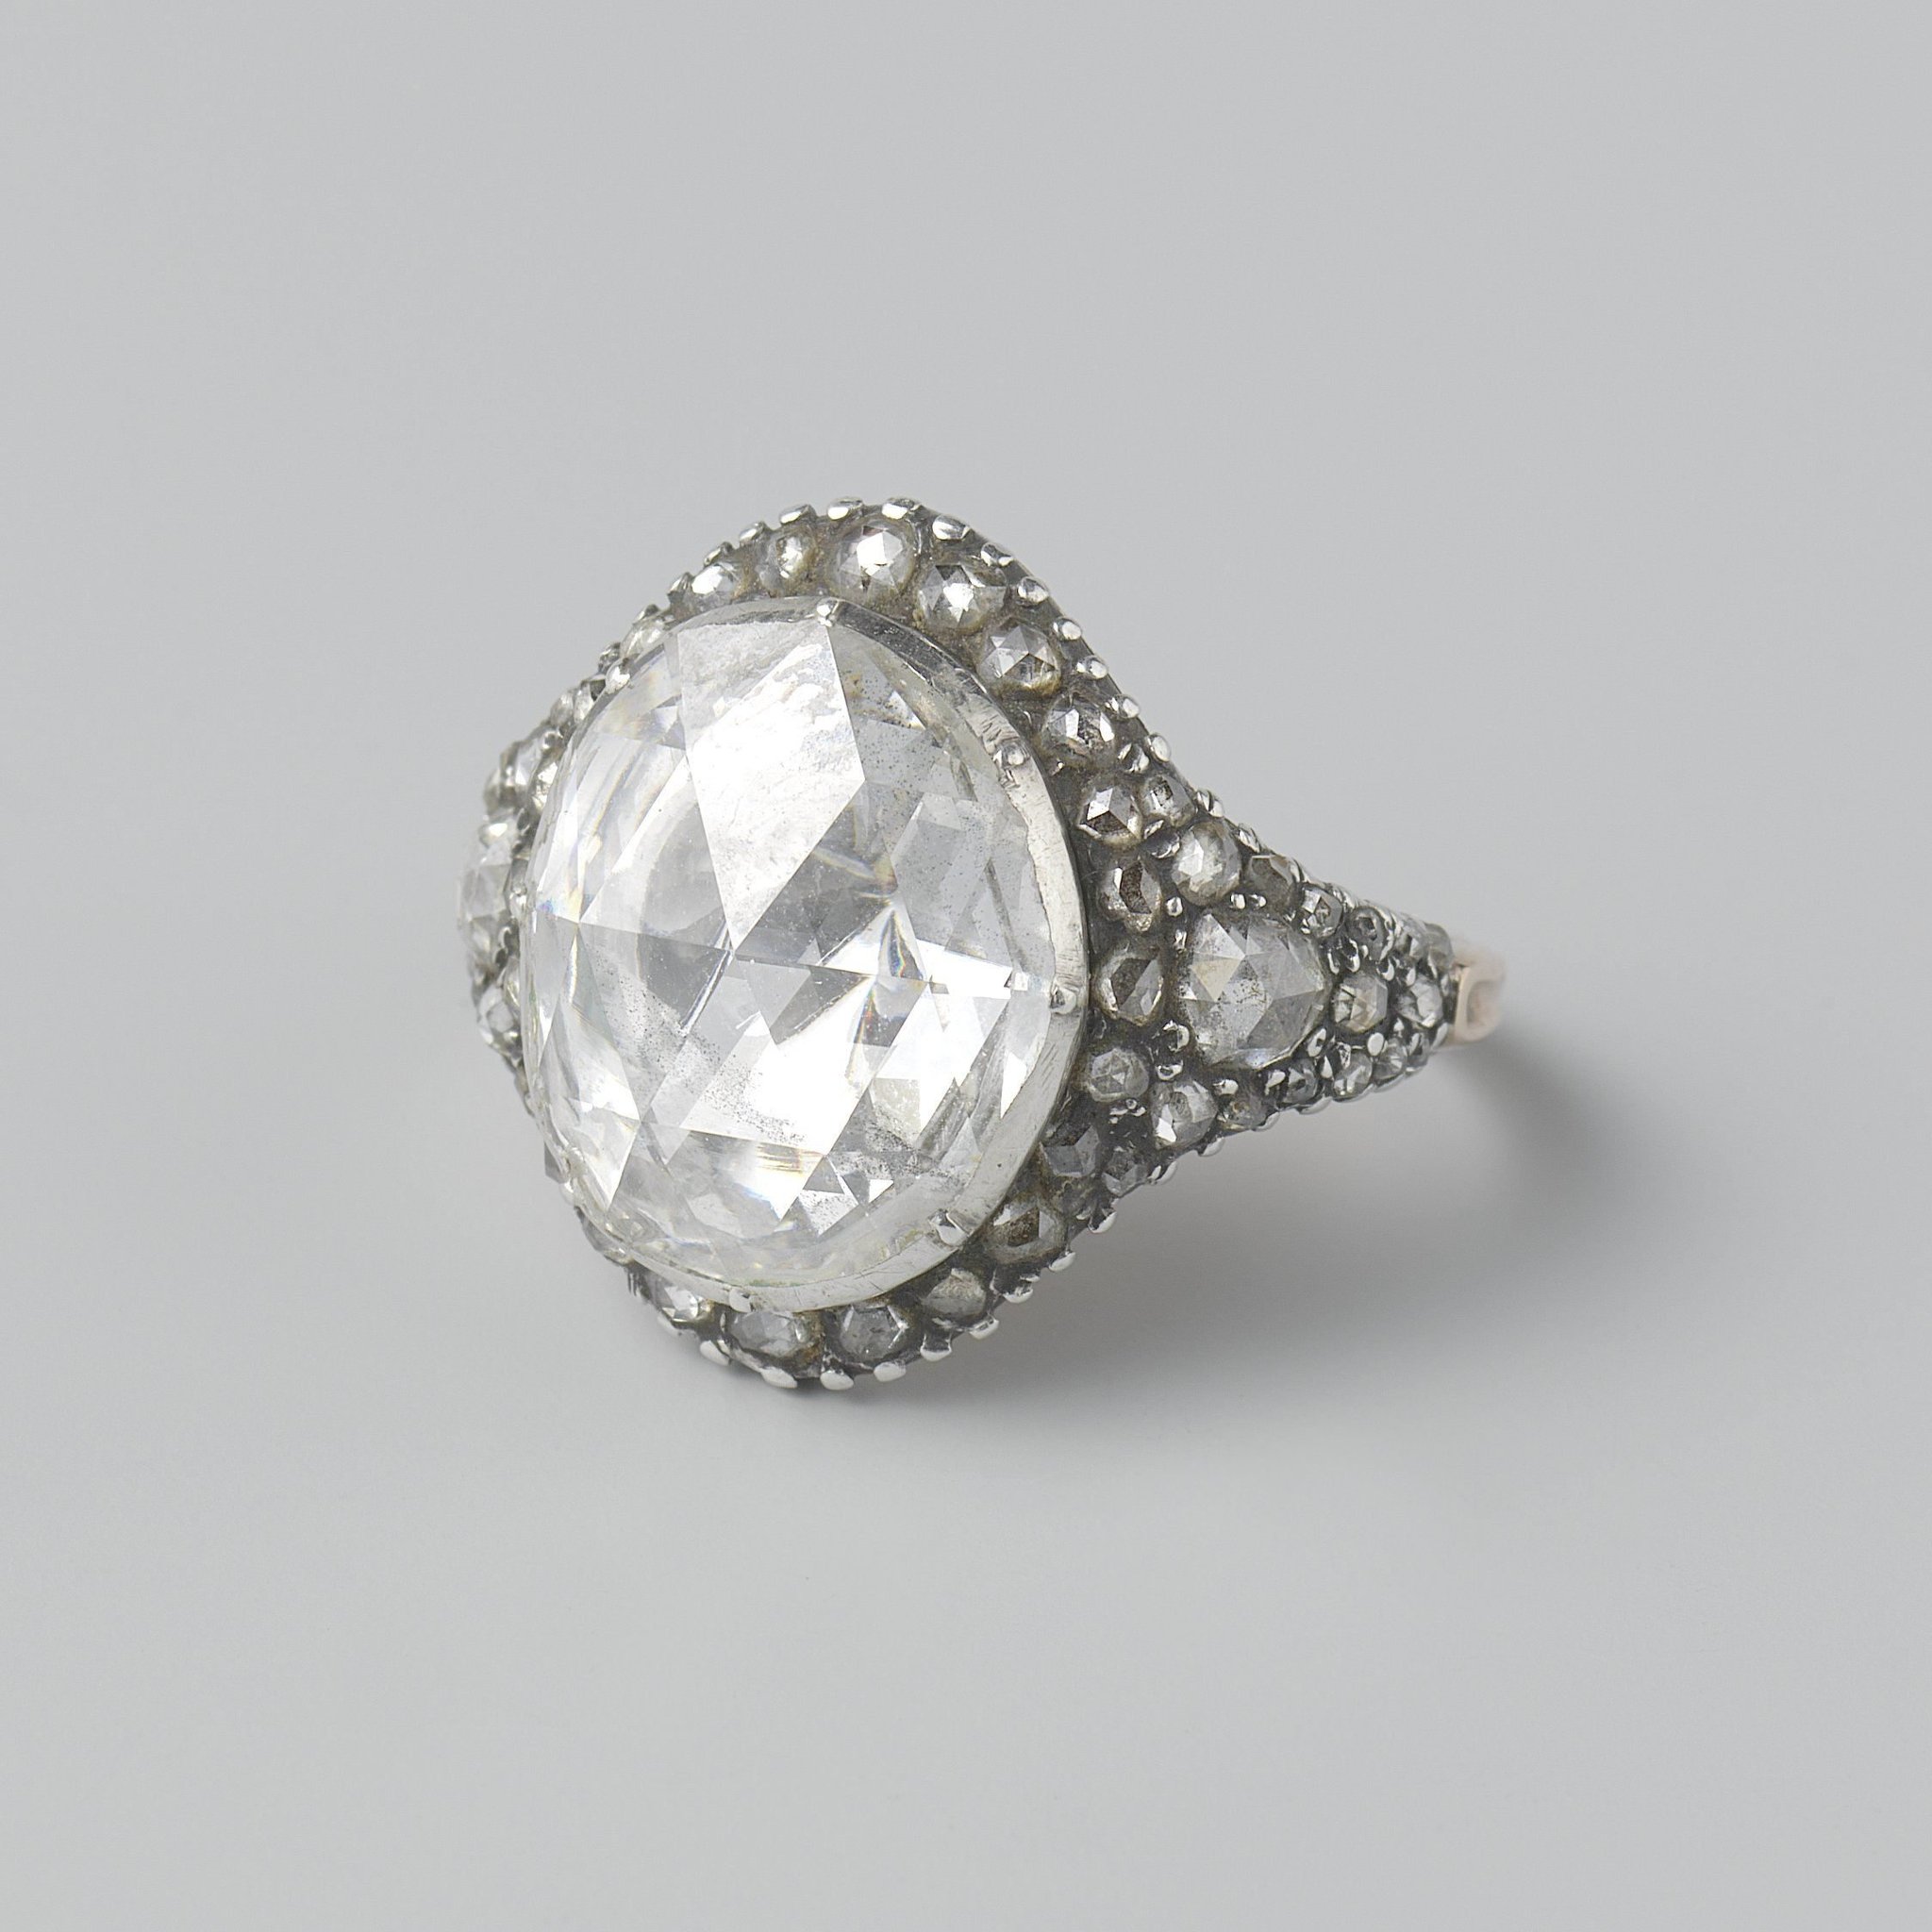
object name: ring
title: Rings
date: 1725-1750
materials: diamond, gold, silver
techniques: grinding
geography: istanbul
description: Before the 19th century, men wore different types of rings to underline their power, wealth and prestige. The wearers of these particular rings were a bishop of the Catholic Church, a Dutch diplomat, and an administrator in Stadholder William V’s treasury. Today, wedding rings and signet rings still indicate their wearers’ social status, but often in more austere forms.